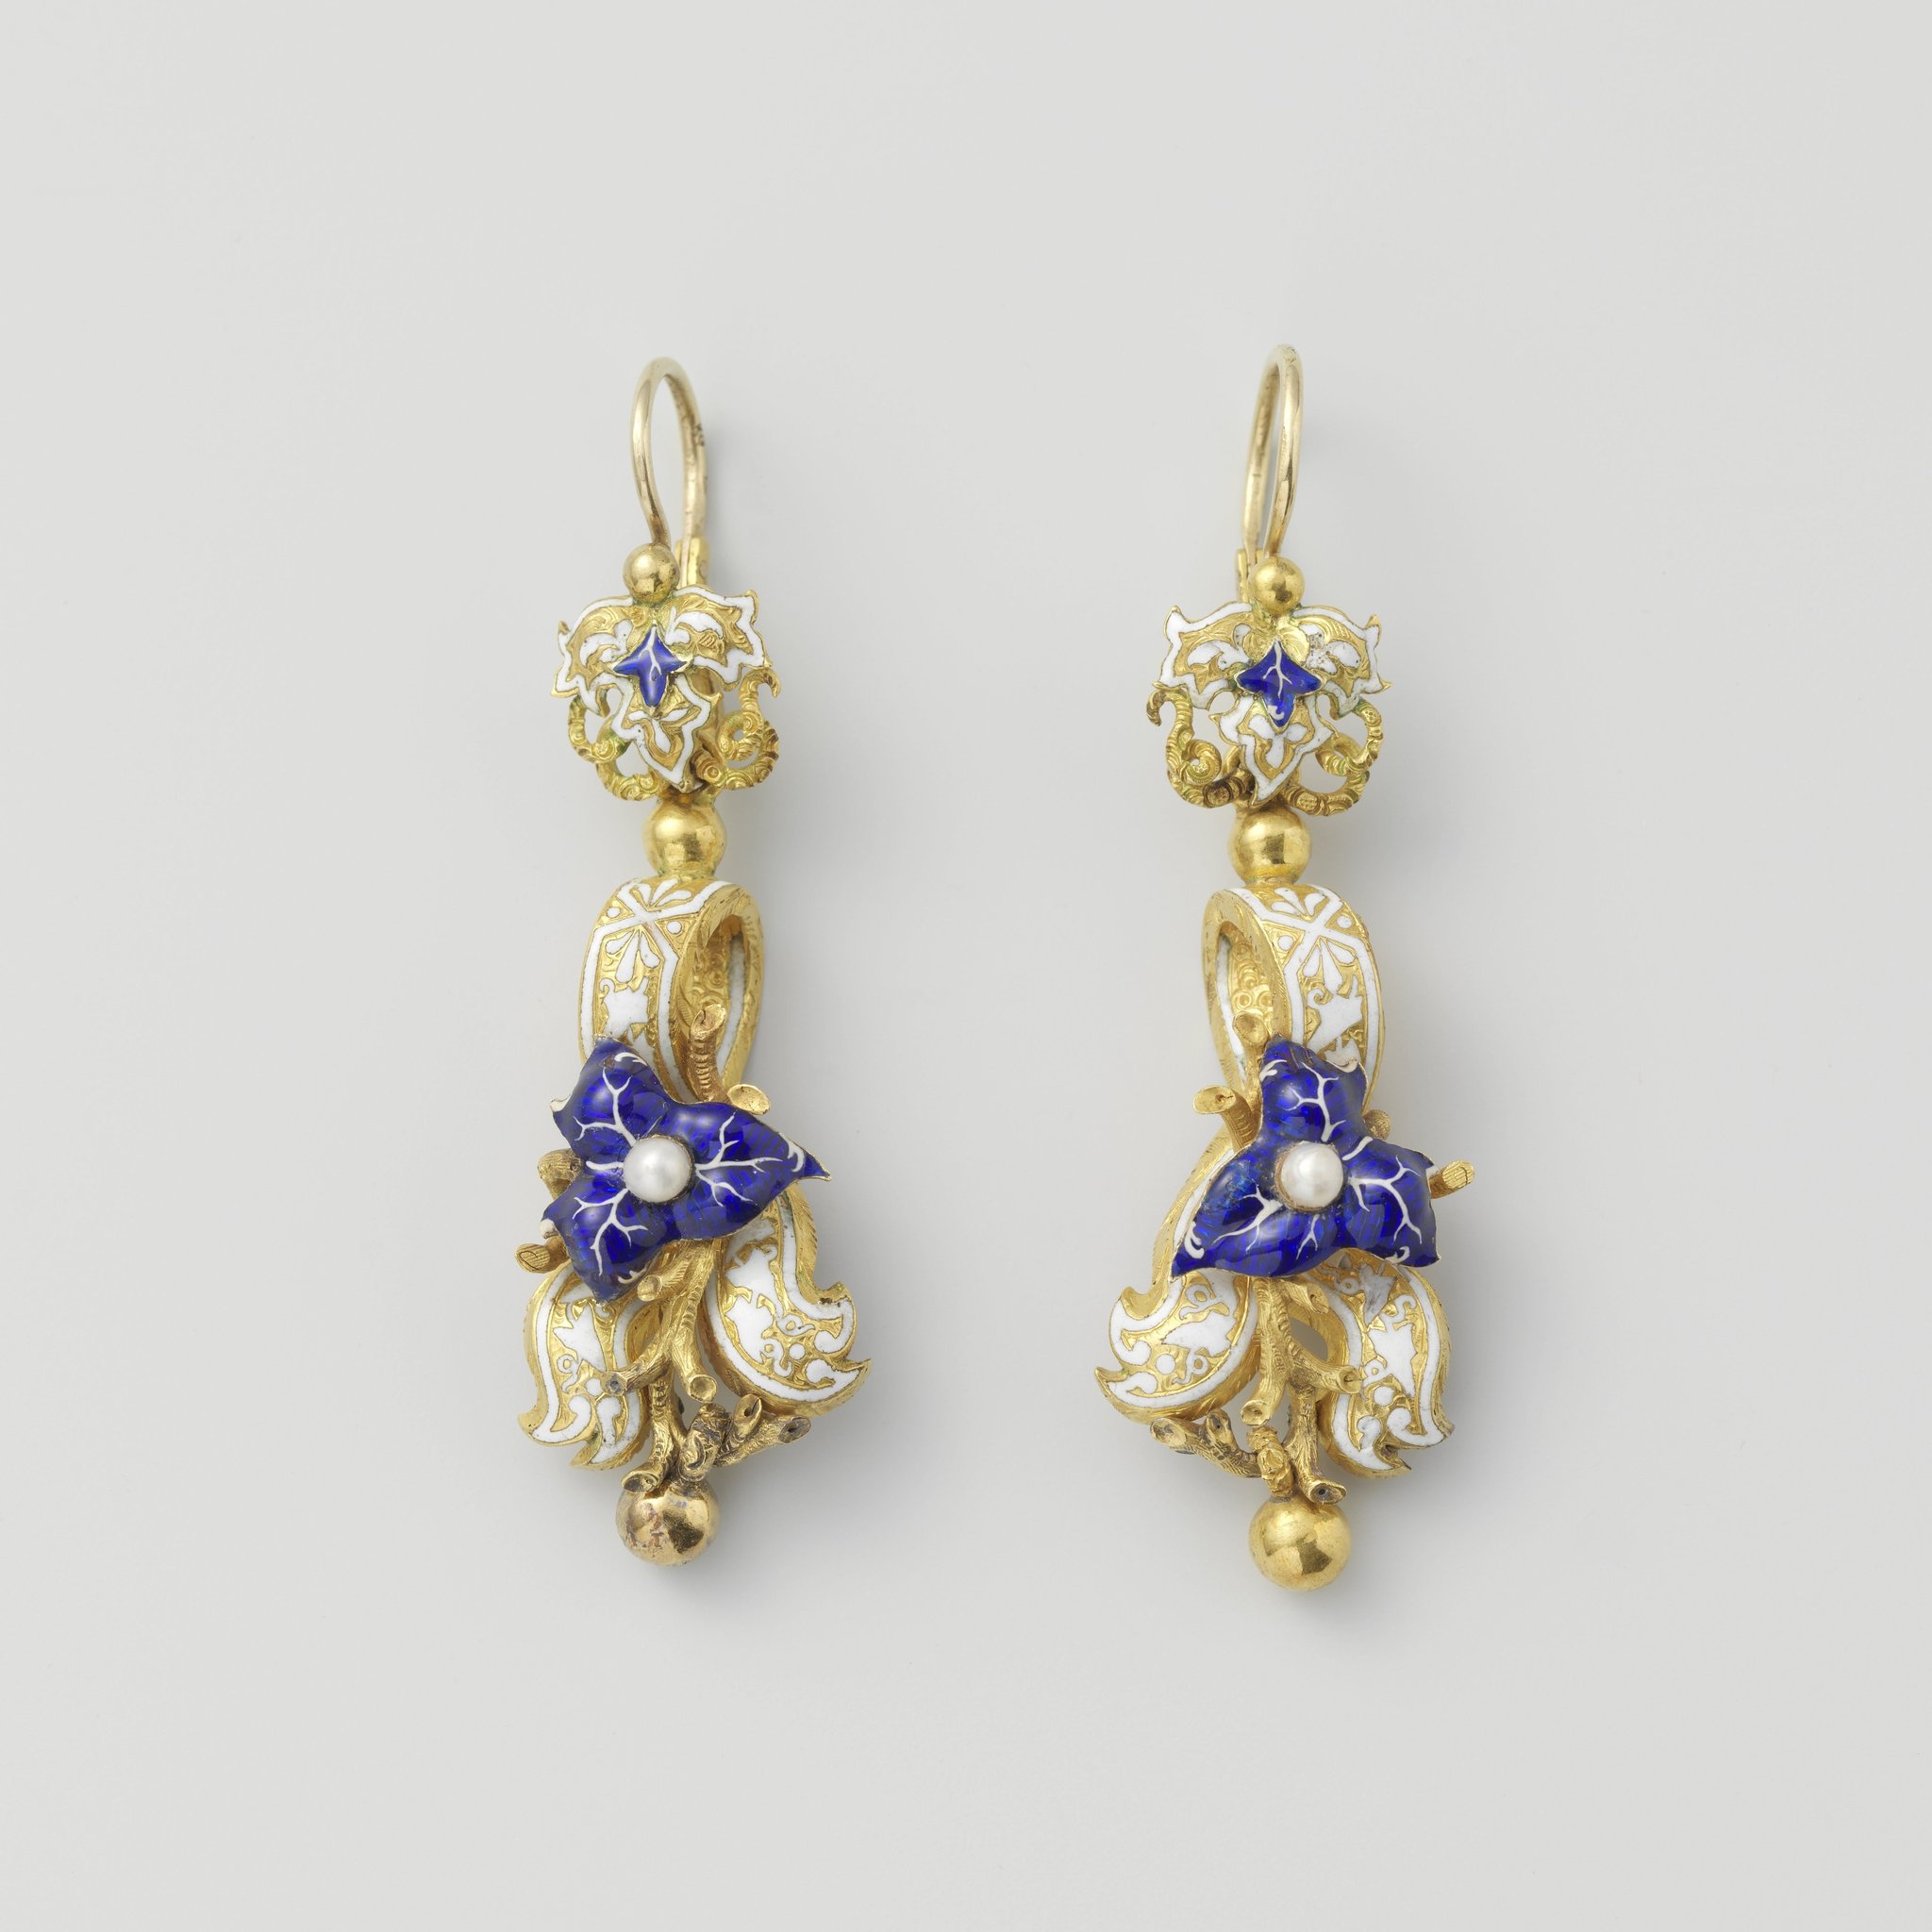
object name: ear ornament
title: Een paar oorhangers, deel van een demi-parure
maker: Anonymous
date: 1840-1849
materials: diamond, gold, pearl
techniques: enameling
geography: germany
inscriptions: mark: ‘IL (?) in rechthoek’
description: Parure. Gold, diamonds, pearls and enamel. Germany (?), c. 1840 - 1850.